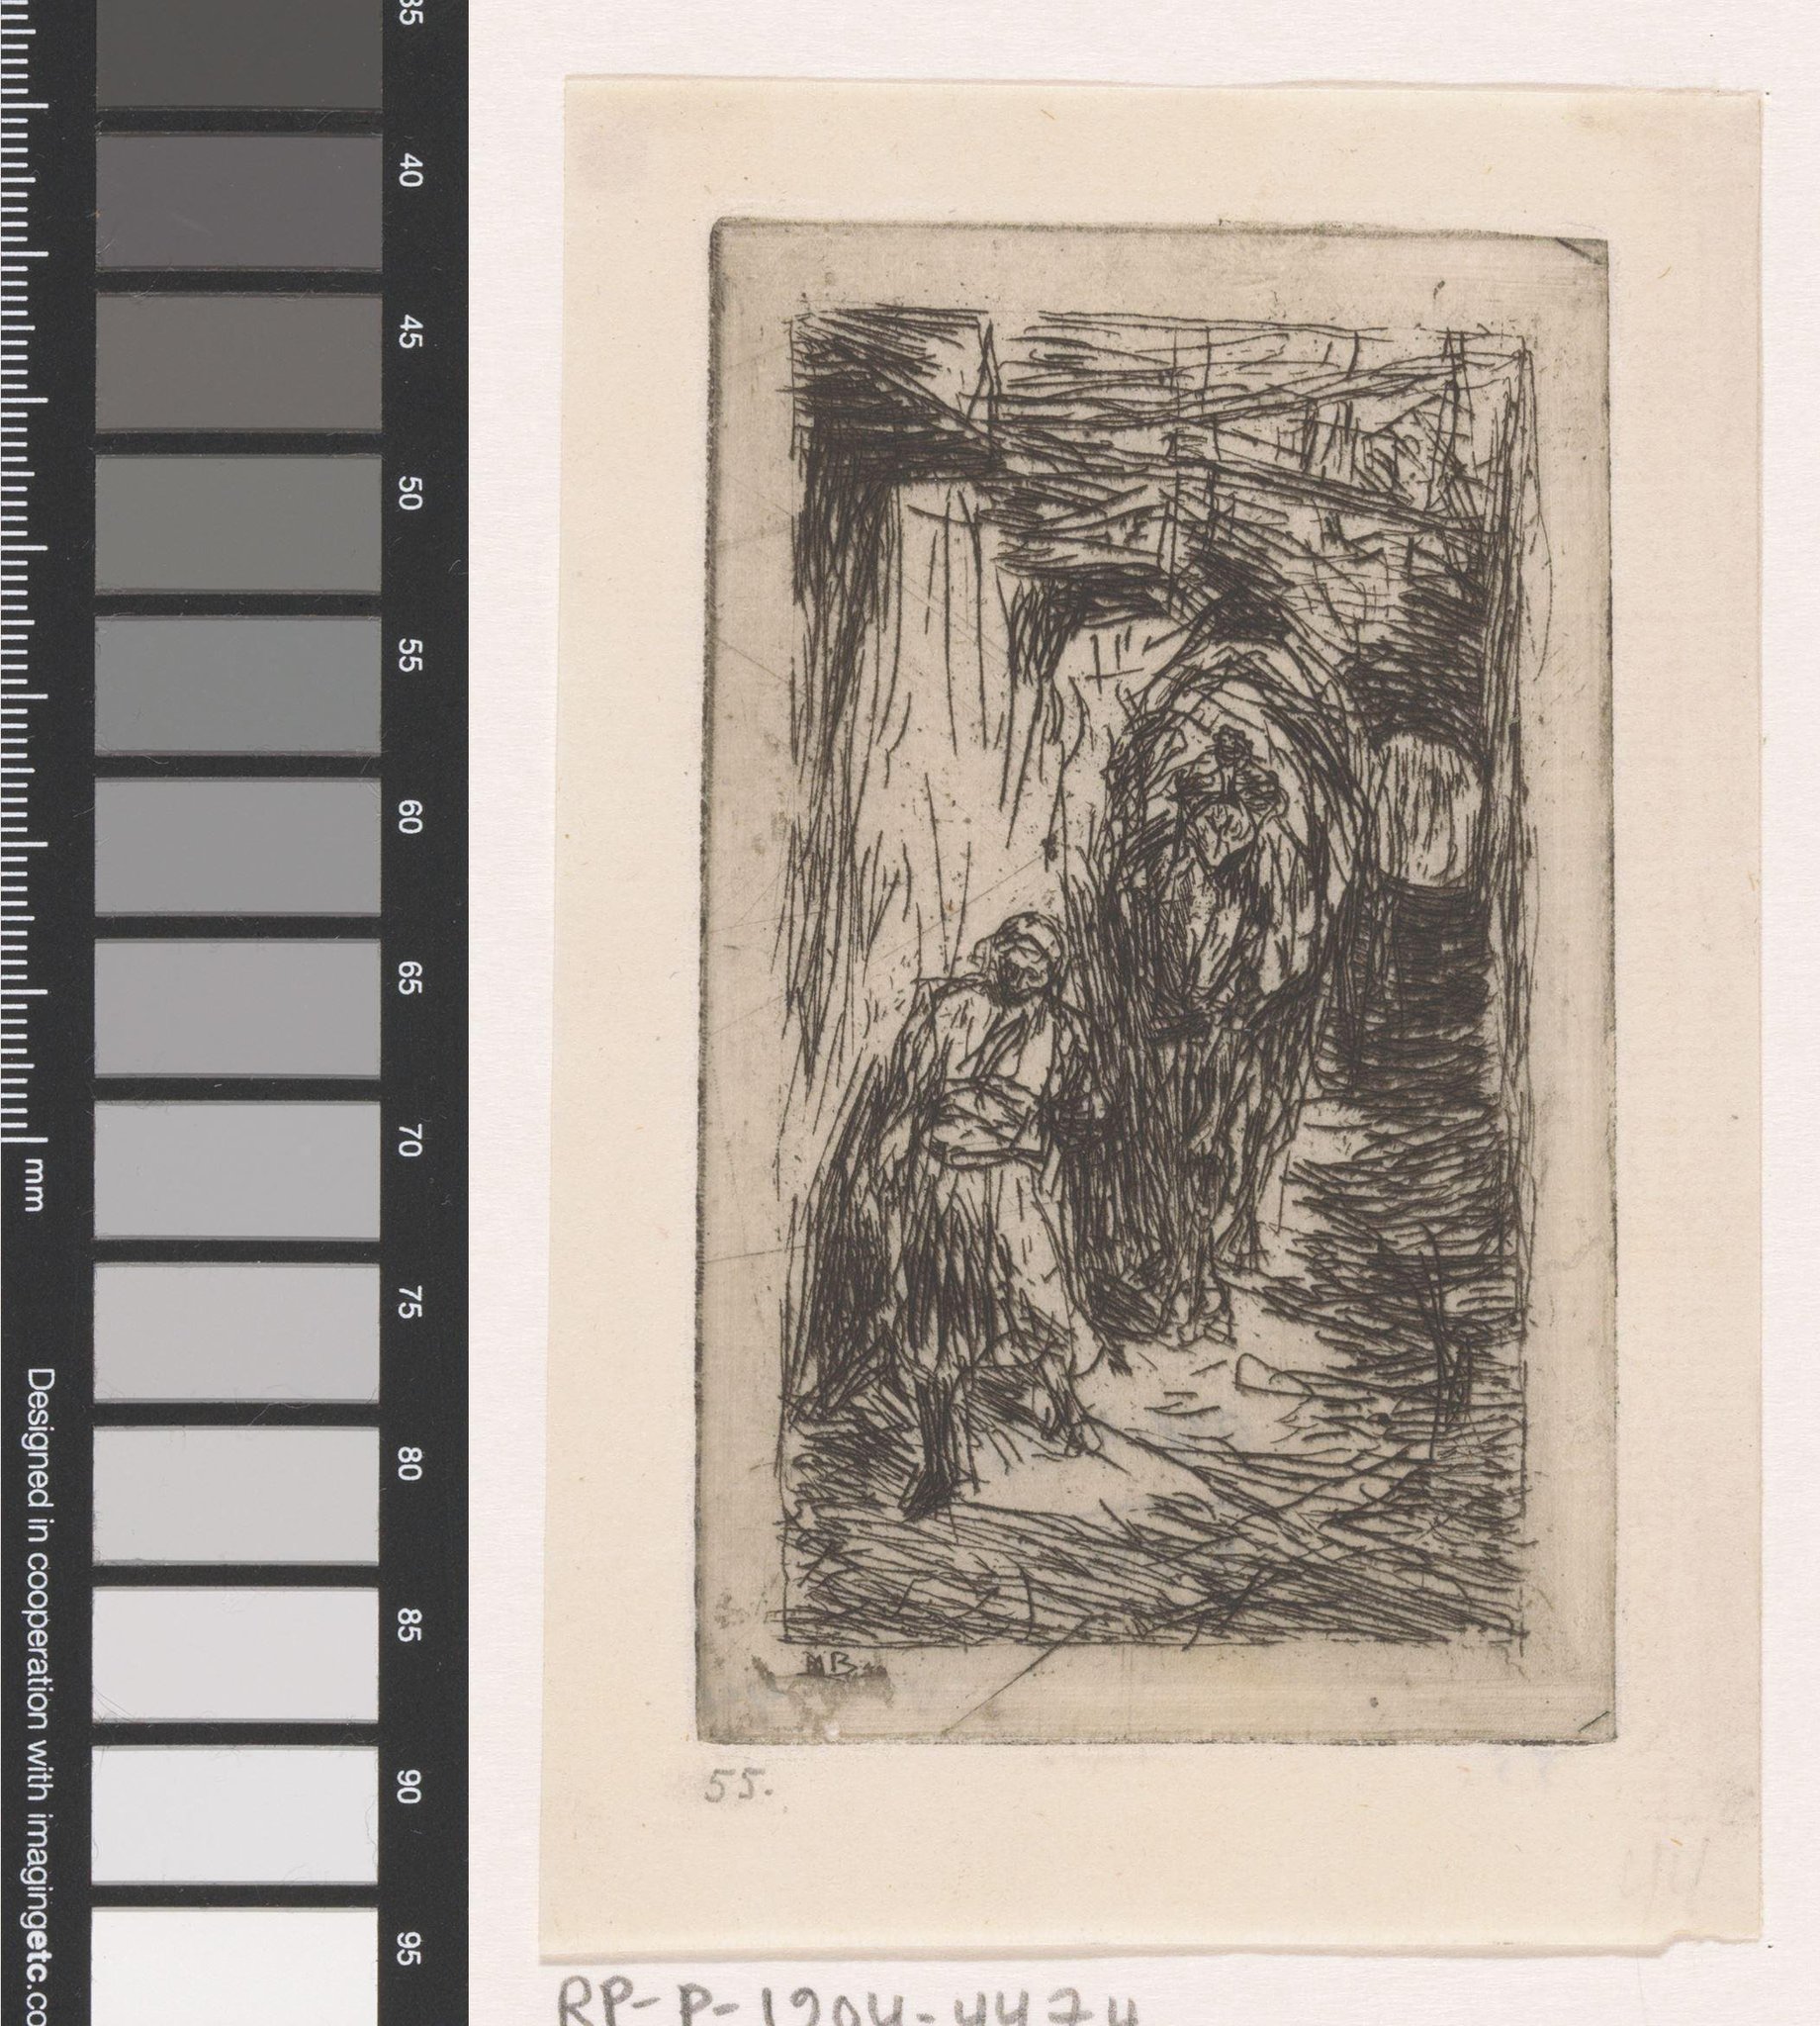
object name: print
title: Kameeldrijver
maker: marius bauer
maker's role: draughtsman, print maker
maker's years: 1867-1932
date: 1889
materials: paper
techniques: intaglio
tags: hoofed animals: camel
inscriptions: collector's mark: Lugt 2228, number: ‘55’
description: Een man in oosterse kleding met een kameel die een vracht vervoert op straat.